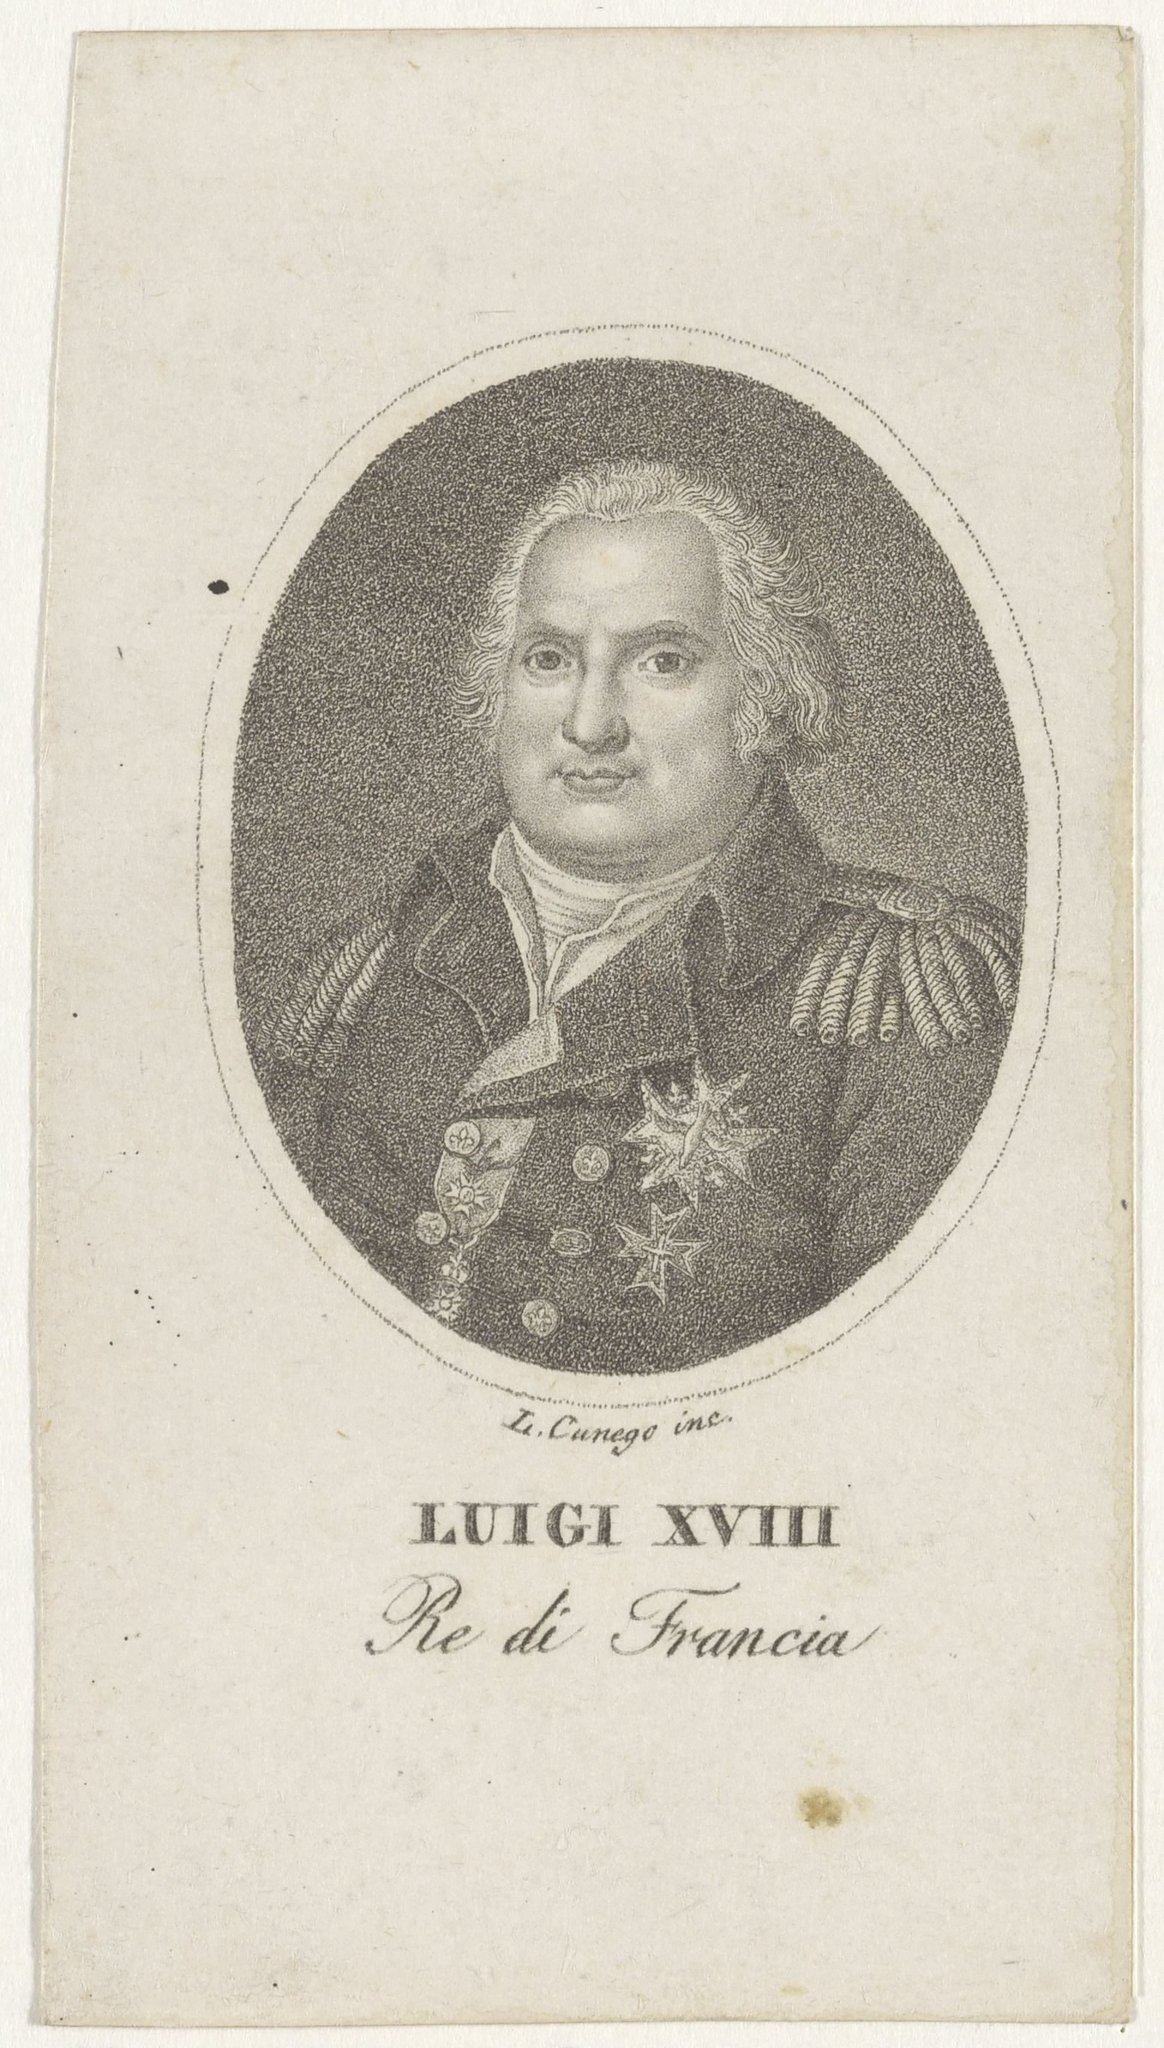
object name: print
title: Portret van Lodewijk XVIII, koning van Frankrijk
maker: luigi cunego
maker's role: print maker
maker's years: 1750-1823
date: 1760-1823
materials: paper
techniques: engraving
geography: italy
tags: paris, lodewijk xviii (koning van frankrijk), historical persons, ruler, sovereign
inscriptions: collector's mark: Lugt 2228